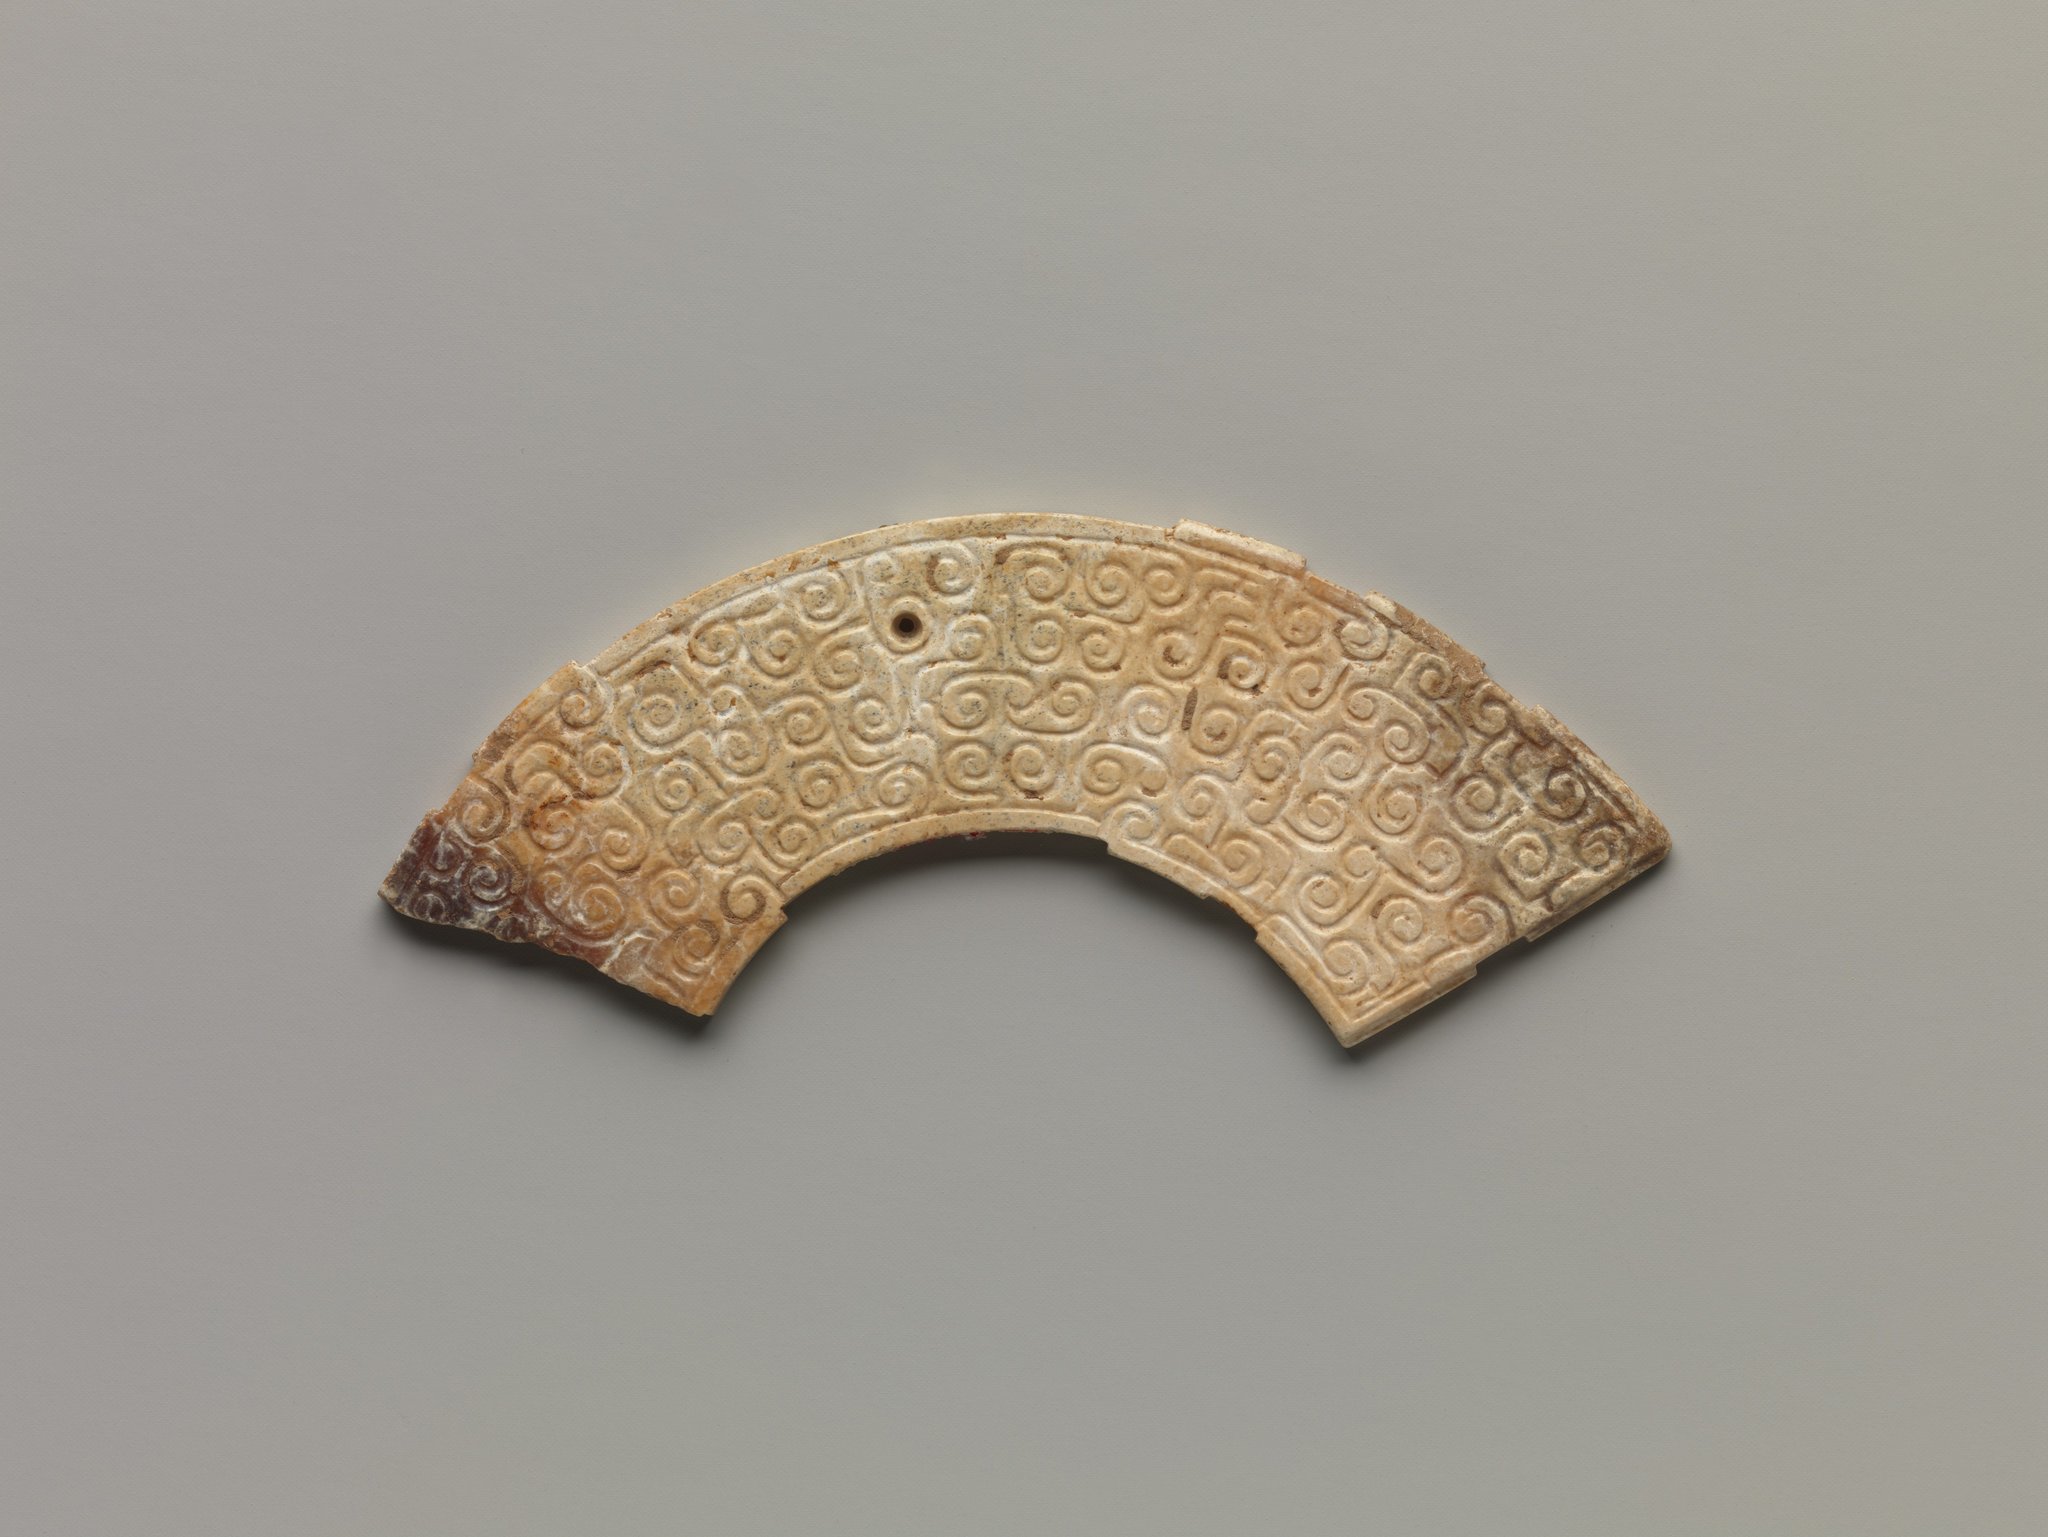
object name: pendant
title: Arc-shaped pendant (Huang)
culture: chinese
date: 500-401 BCE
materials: jade